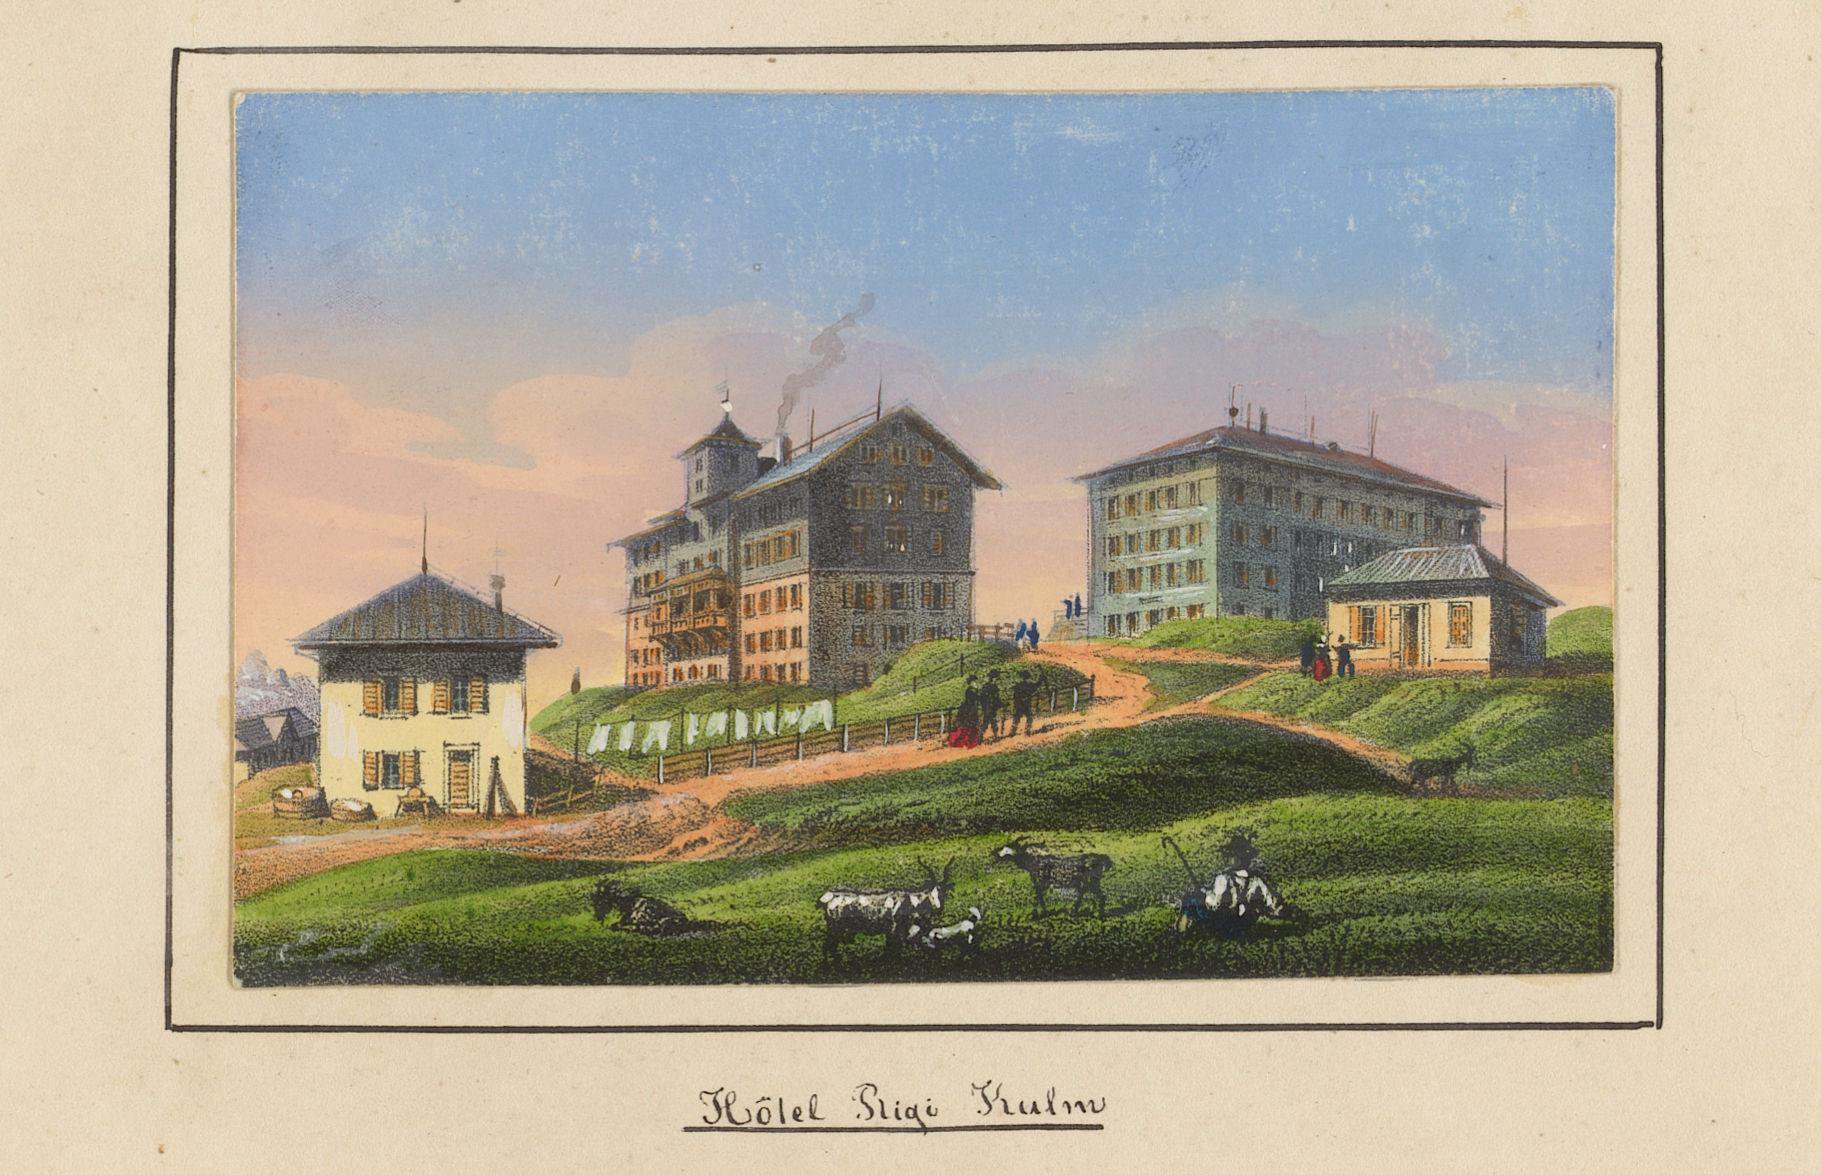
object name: album leaf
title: Hotel Rigi Kulm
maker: Anonymous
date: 1865-1875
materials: paper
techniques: photograph, hand coloring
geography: rigi kulm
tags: herding, herdsman, herdswoman, shepherd, shepherdess, cowherd, etc., hotel, hostelry, inn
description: Deze prent maakt deel uit van een album.